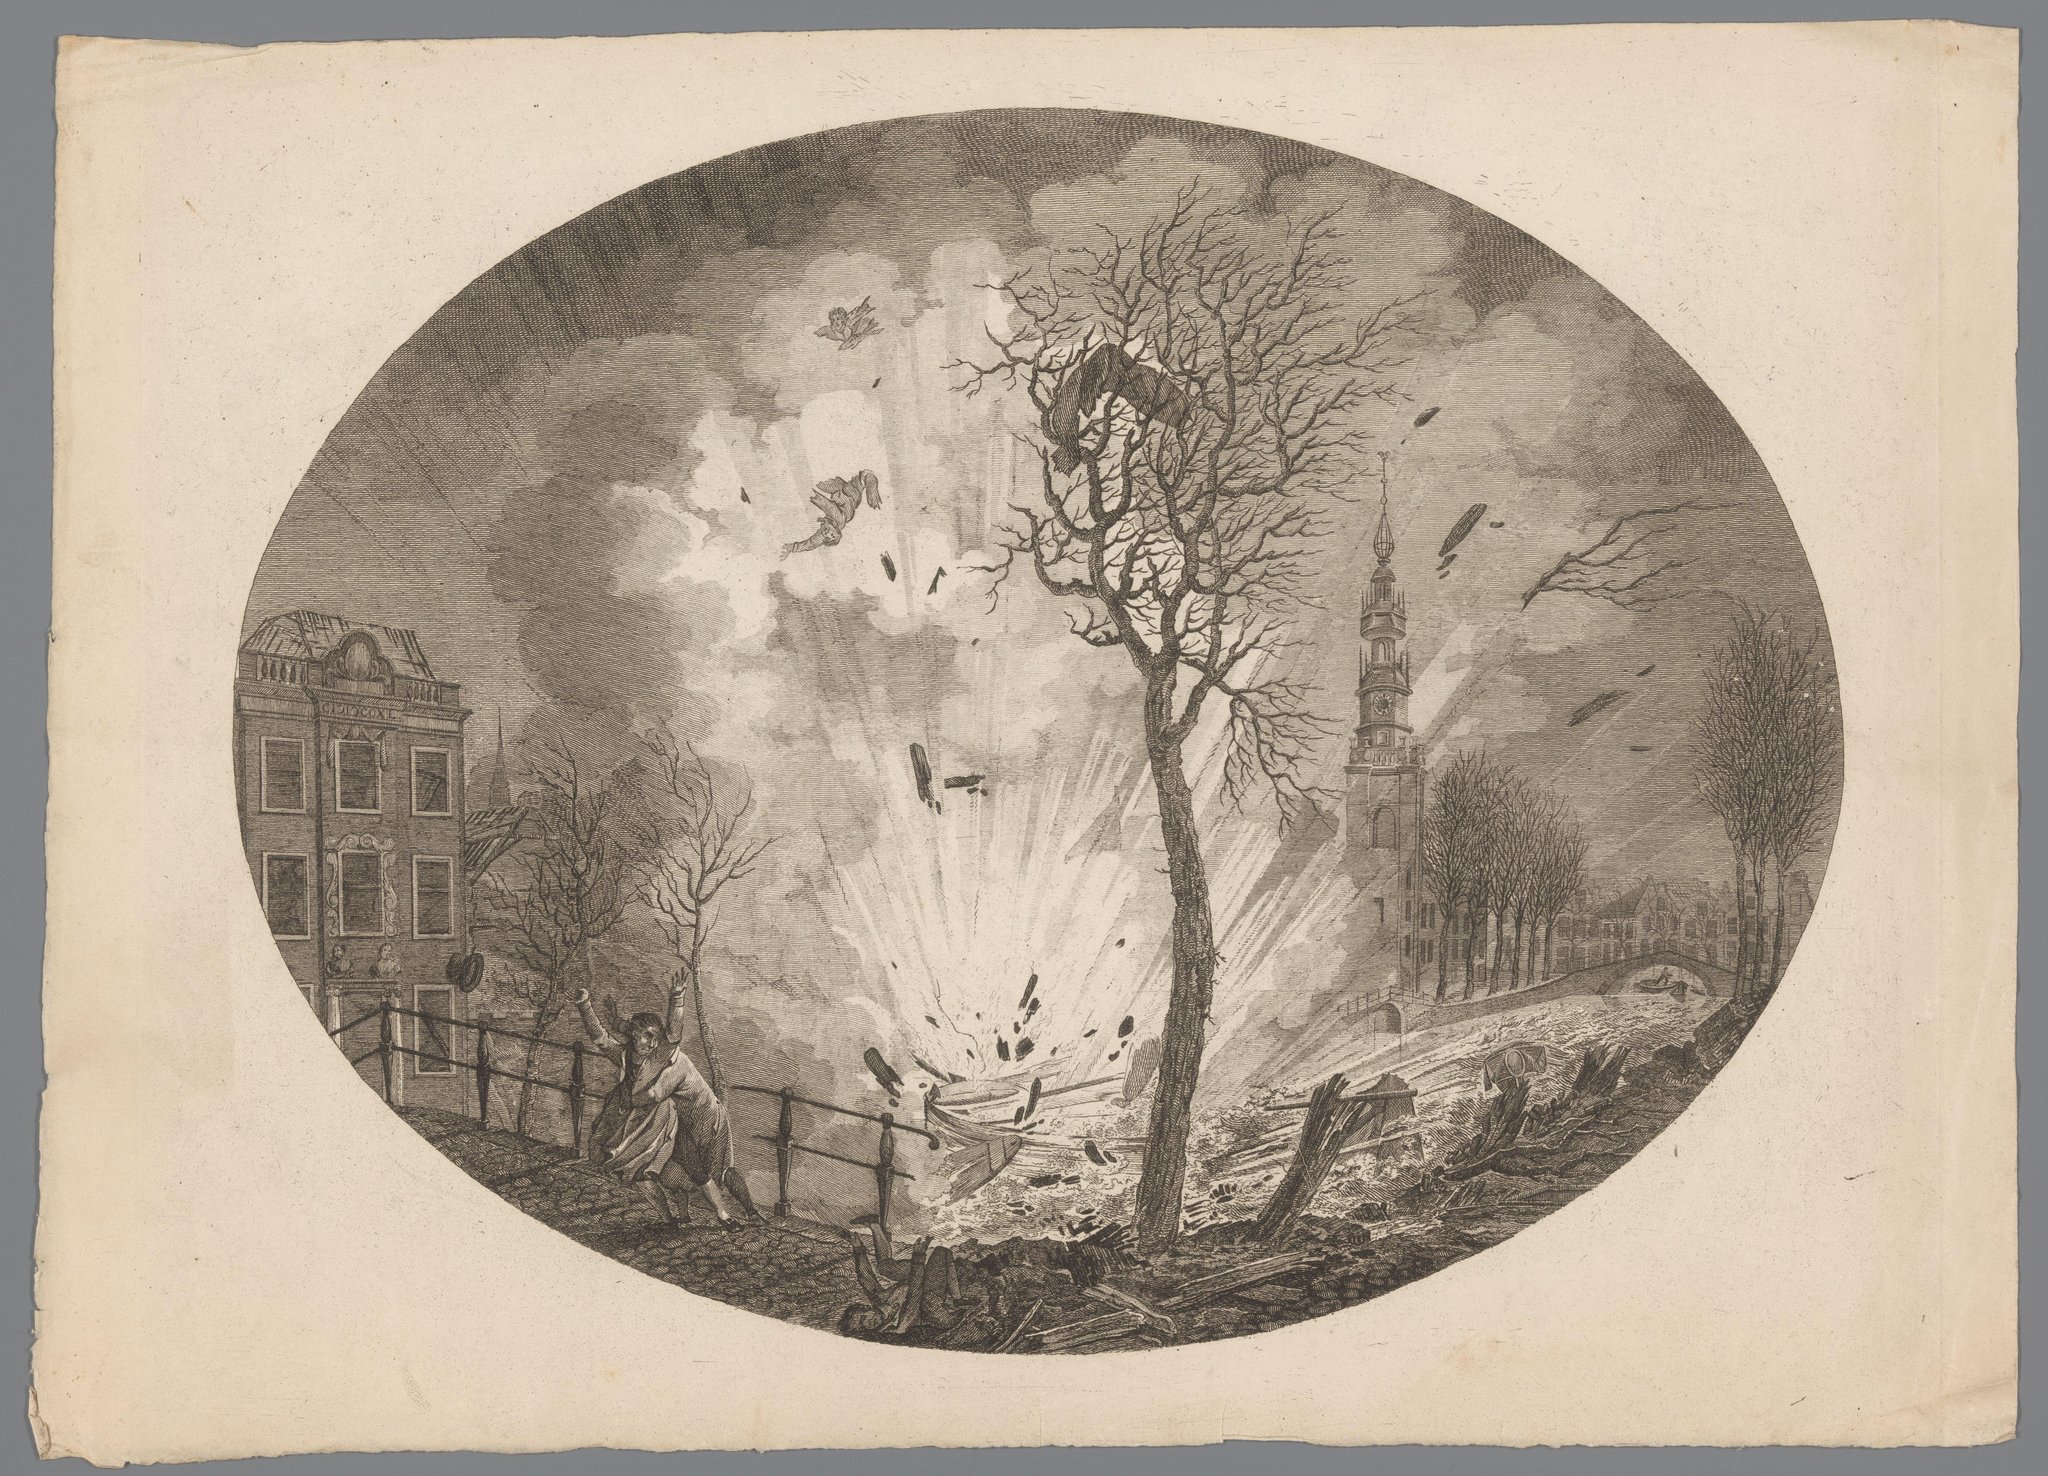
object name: print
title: Buskruitramp te Leiden, 1807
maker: joannes bemme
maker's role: print maker, printer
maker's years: 1775-1841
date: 1807-1809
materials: paper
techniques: etching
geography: netherlands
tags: gunpowder disaster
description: Ovale voorstelling van de ontploffing van het schip met buskruit op het het Steenschuur, een gracht in het verlengde van het Rapenburg, te Leiden, de buskruitramp van 12 januari 1807. Op de brug twee personen die elkaar vastgrijpen, lichaamsdelen vliegen door de lucht. Op de achtergrond de Saaihal.